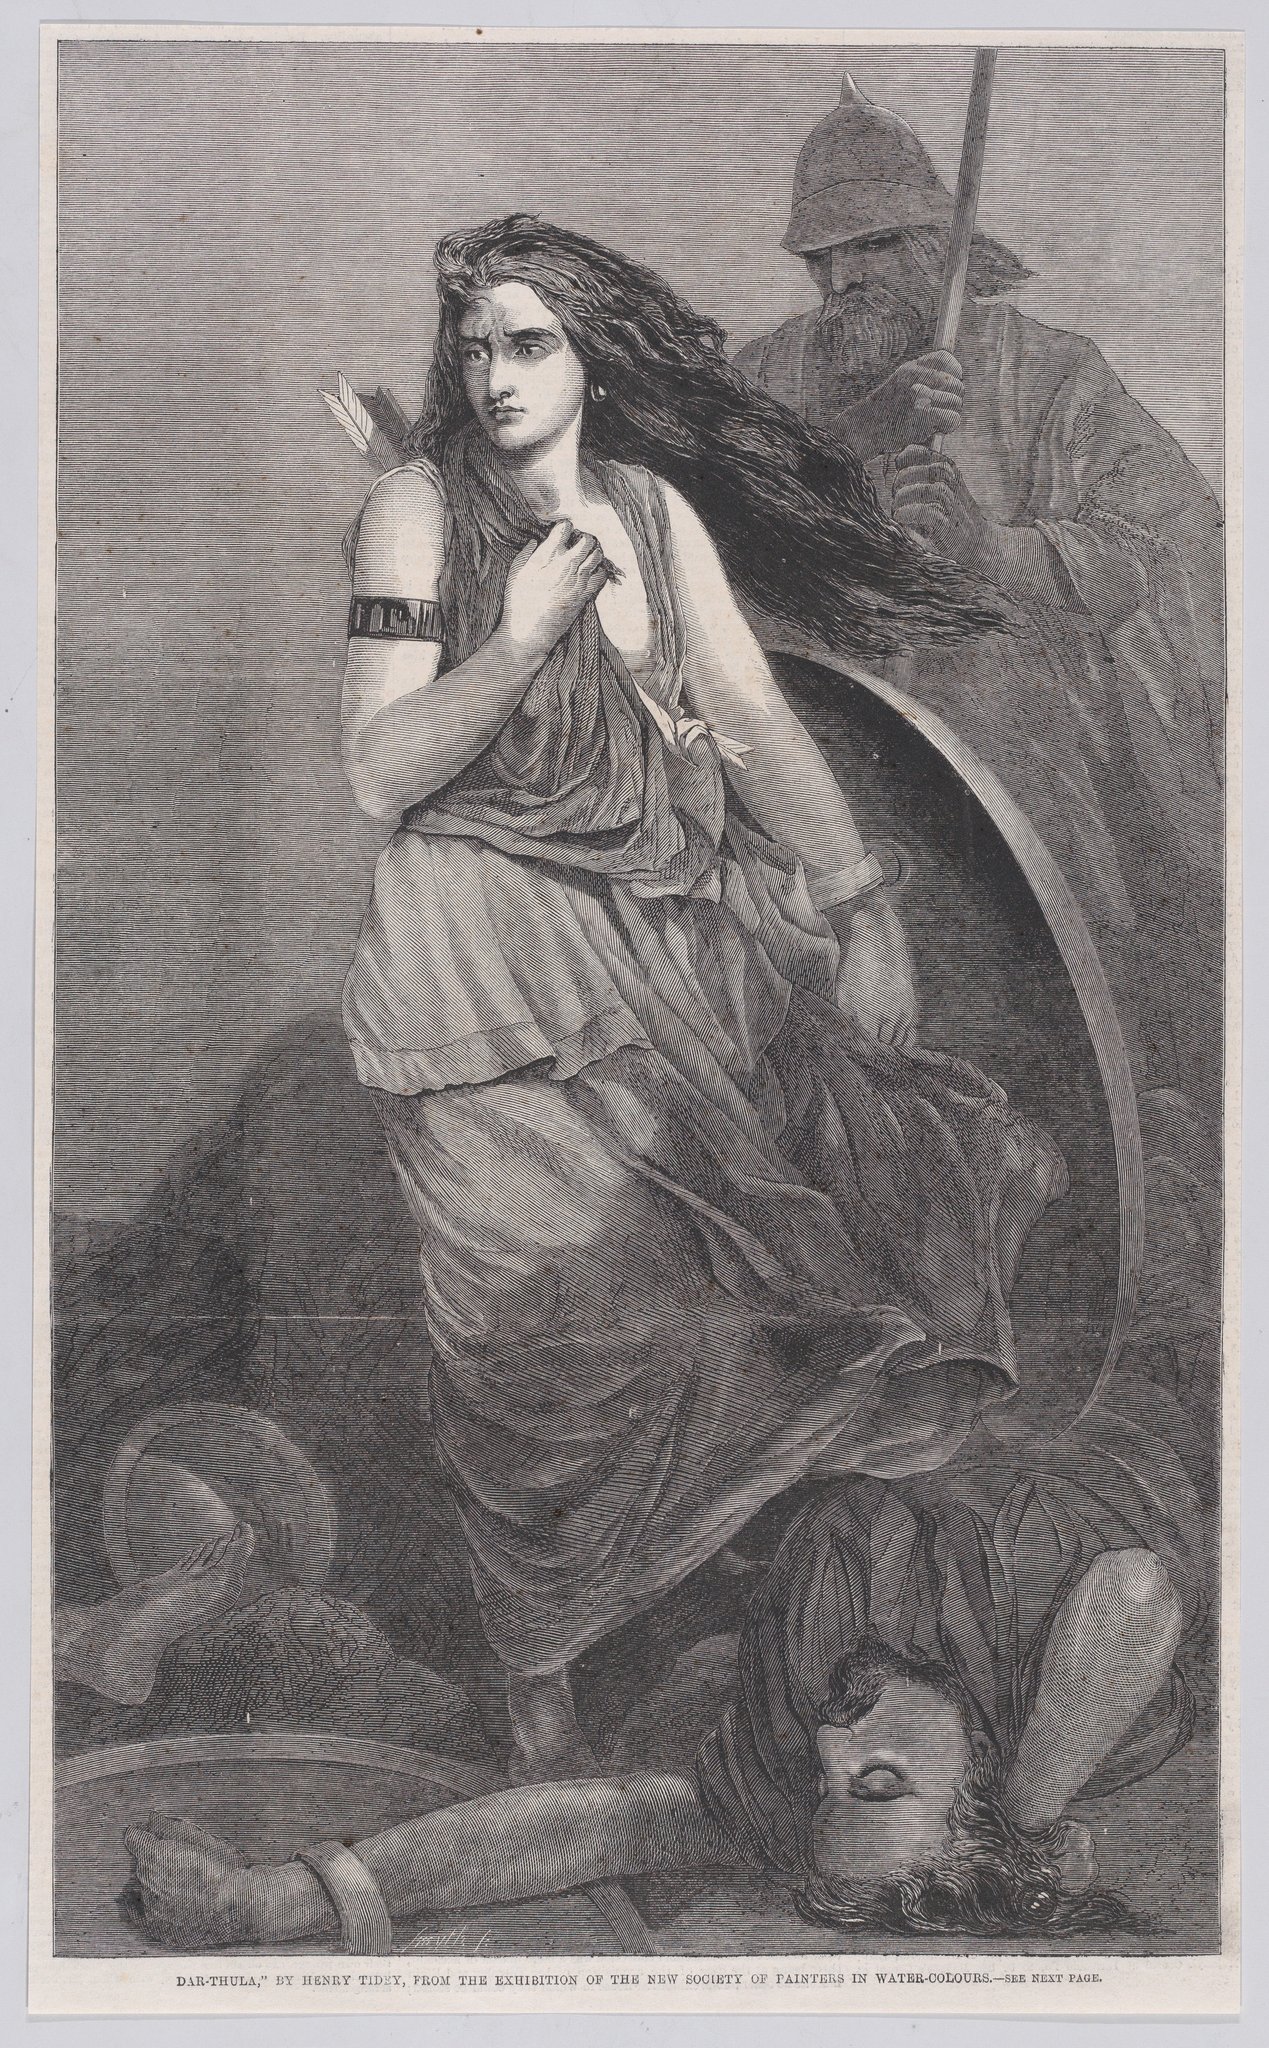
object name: print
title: Dar-Thula, from "Illustrated London News"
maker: frederick james smyth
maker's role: engraver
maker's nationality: british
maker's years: 1841-1867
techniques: engraving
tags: men,women